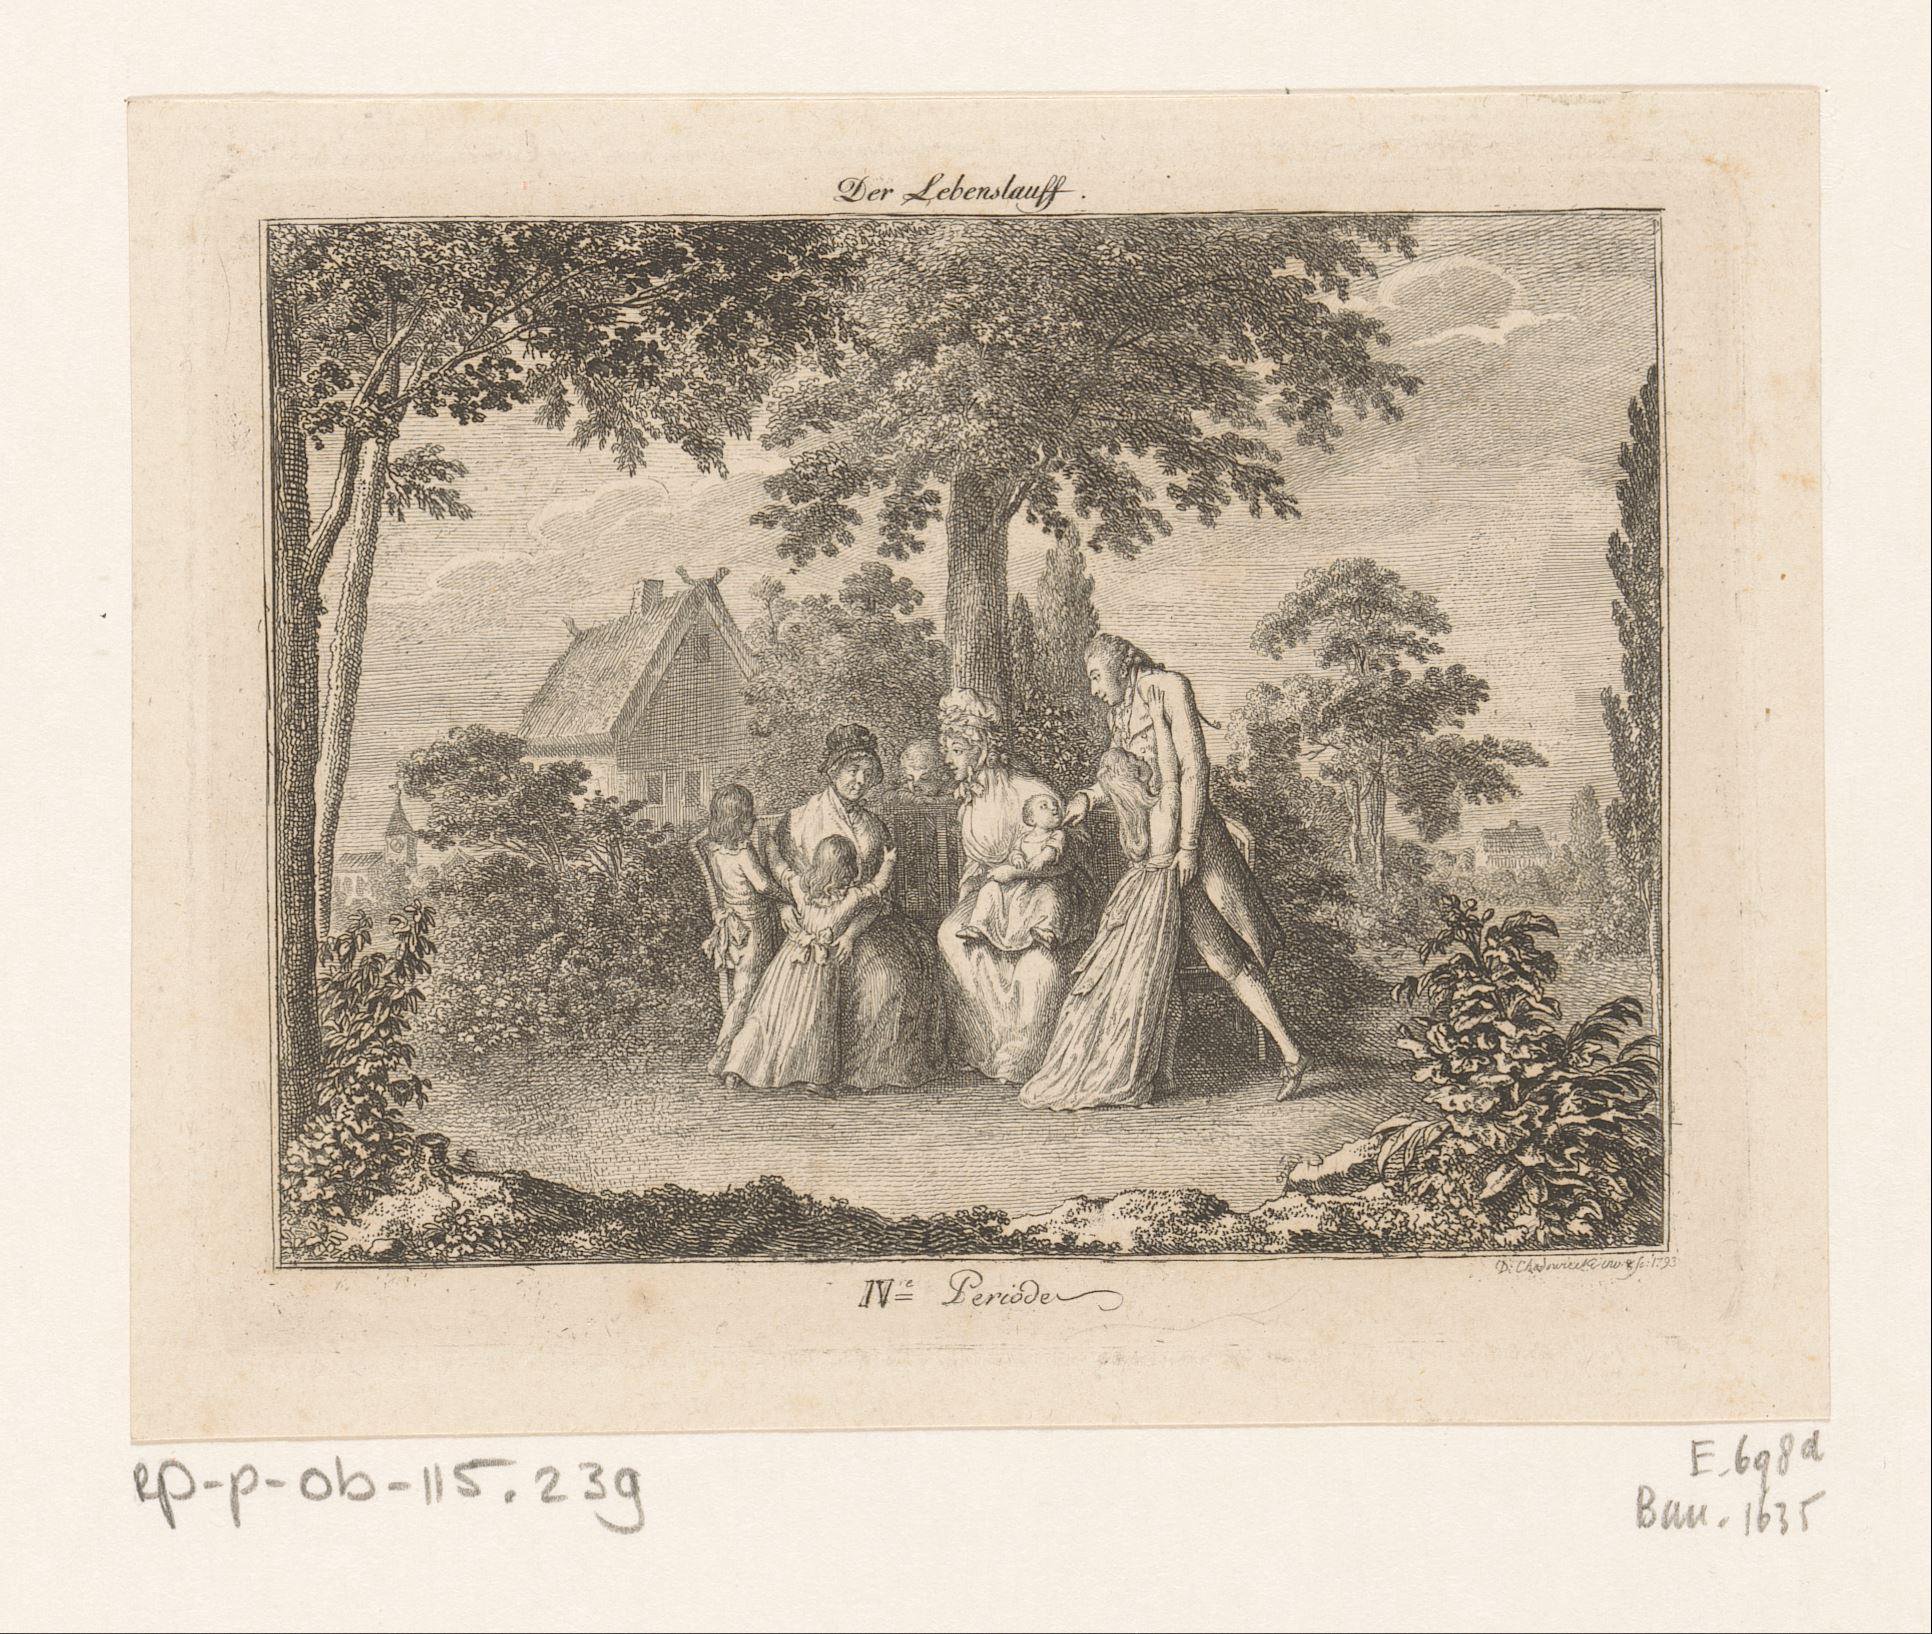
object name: print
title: Gelukkige vader met zijn kinderen als vierde periode van de levensloop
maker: daniel nikolaus chodowiecki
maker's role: draughtsman, print maker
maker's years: 1726-1801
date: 1793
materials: paper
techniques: etching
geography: berlin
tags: bench, father with son(s) and daughter(s) (father-love), adult man, child, farm or solitary house in landscape, the life of man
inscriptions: collector's mark: Lugt 2228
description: Onderdeel van een serie van acht prenten over de levensloop van de mens.